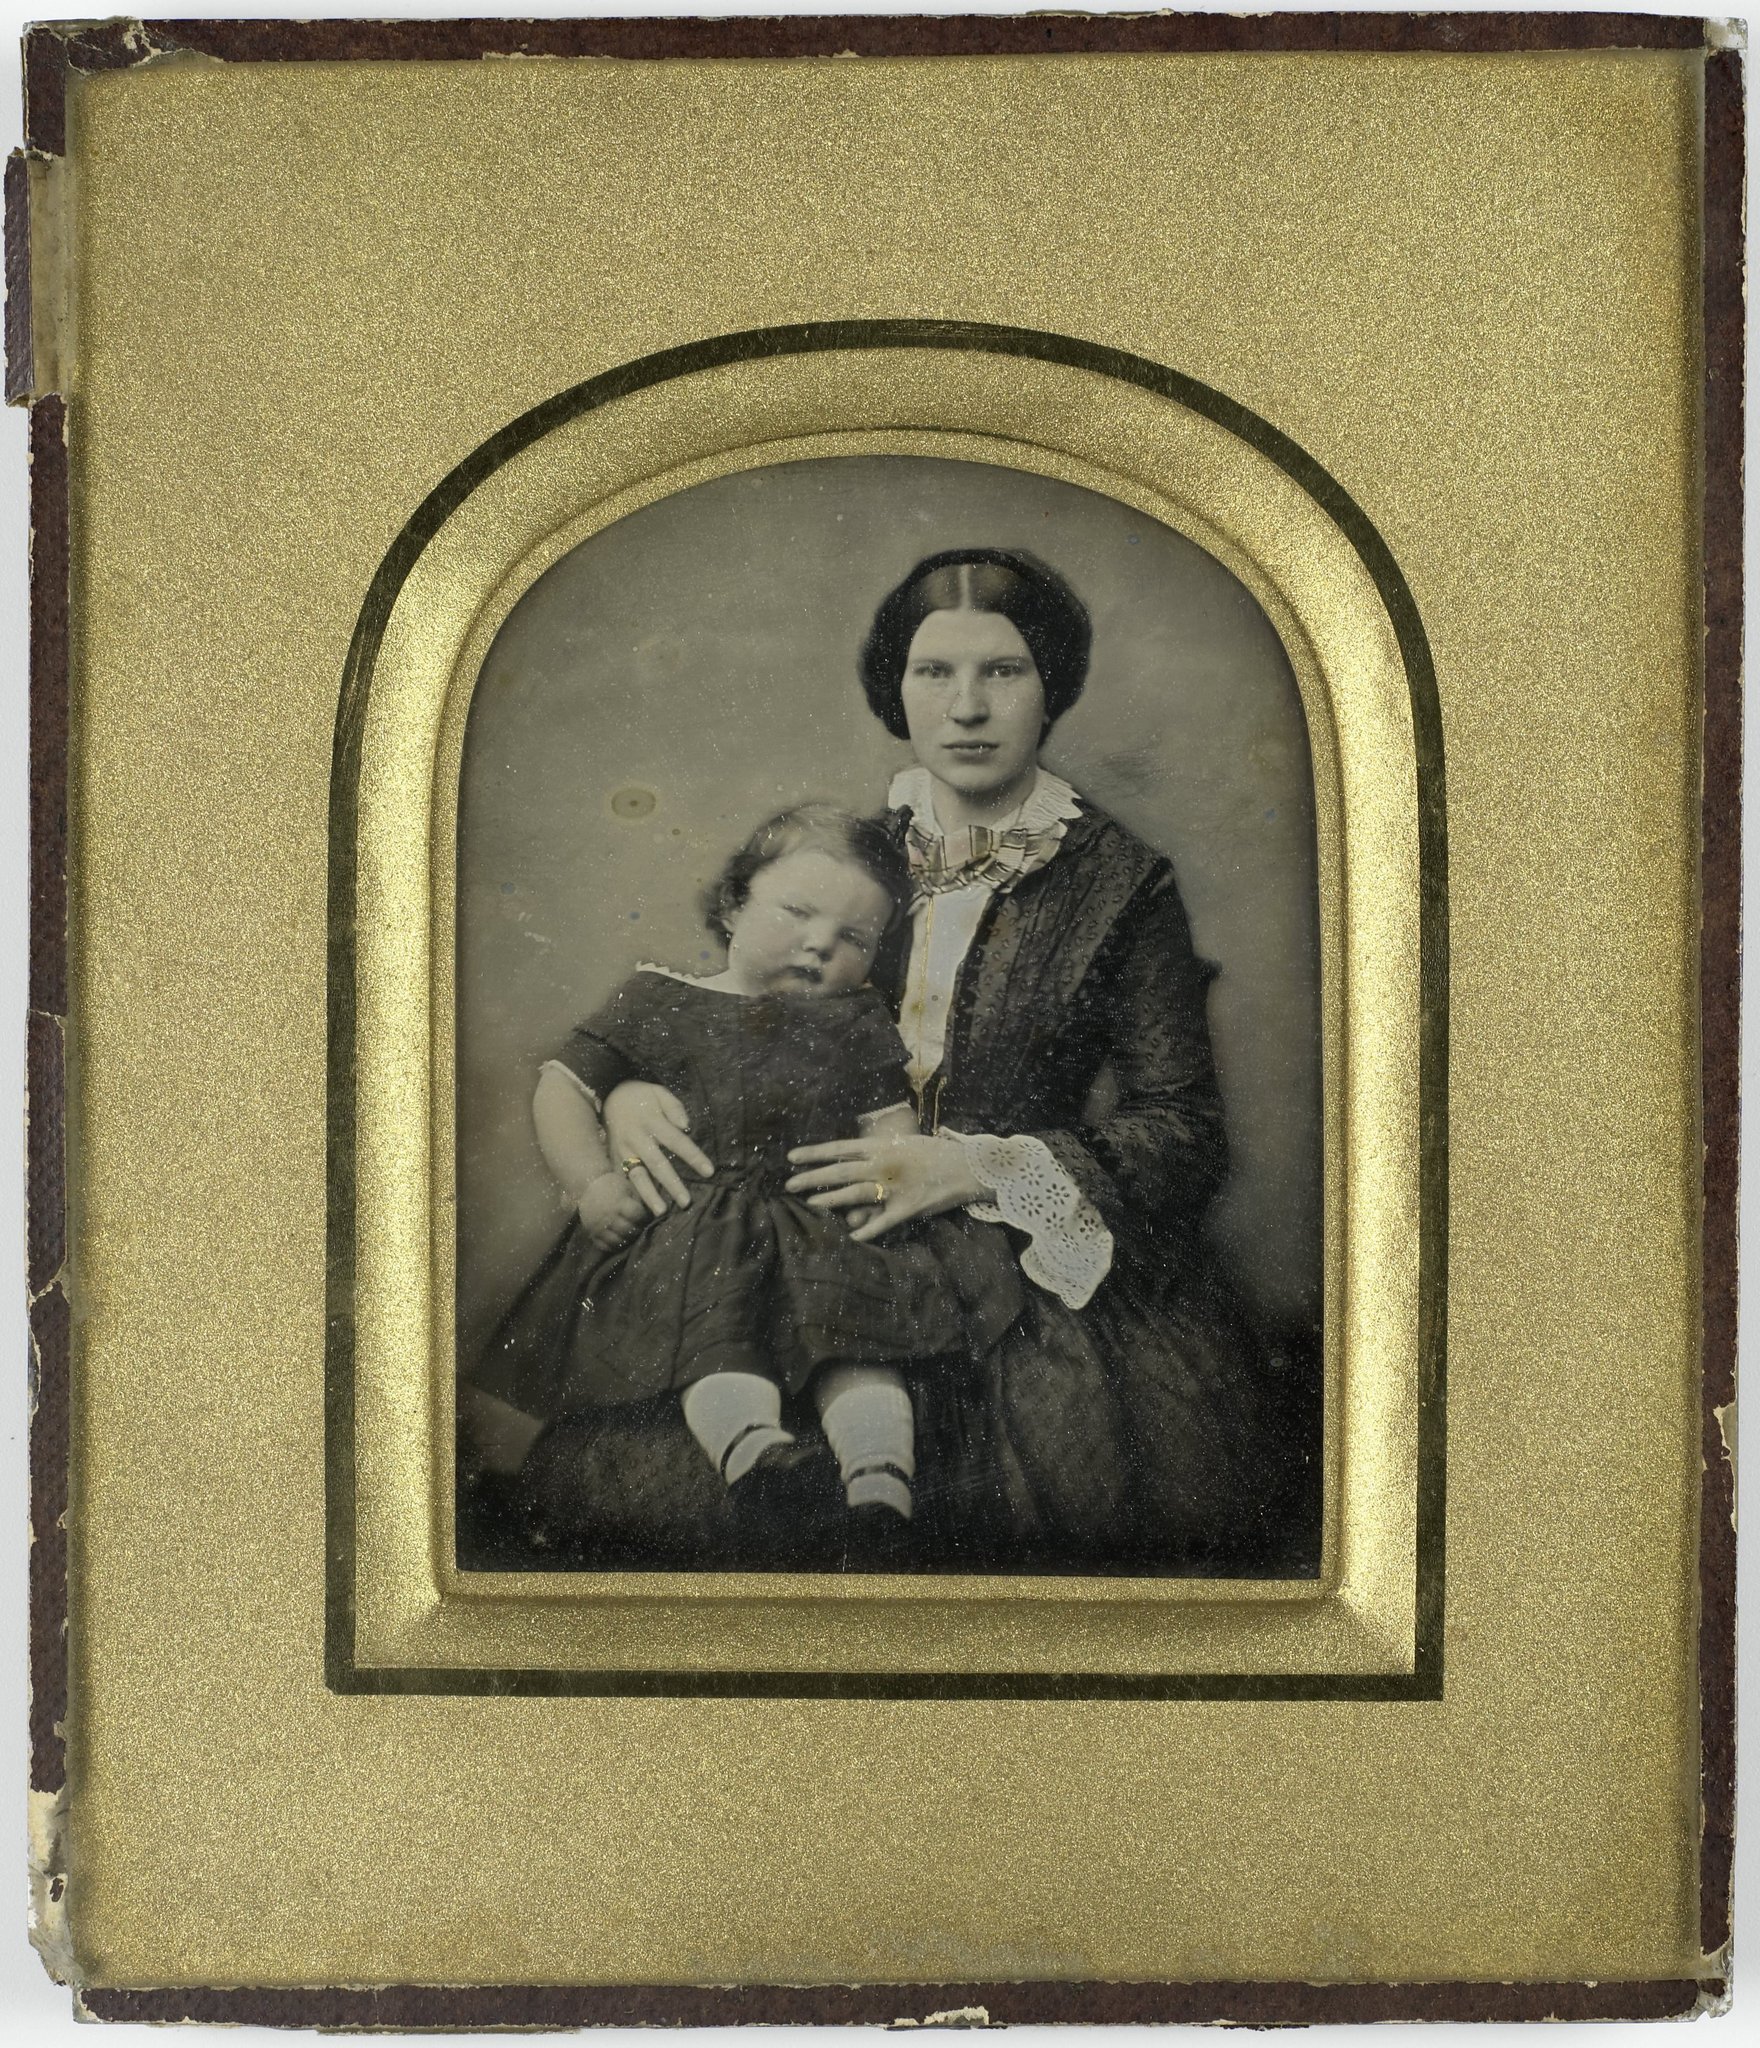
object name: photograph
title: Portret van een onbekende vrouw met kind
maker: Anonymous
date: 1855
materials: copper, glass, paper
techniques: daguerreotype, hand coloring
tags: adult woman, historical persons, child (at home)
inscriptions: inscription: ‘March 13th 1855’